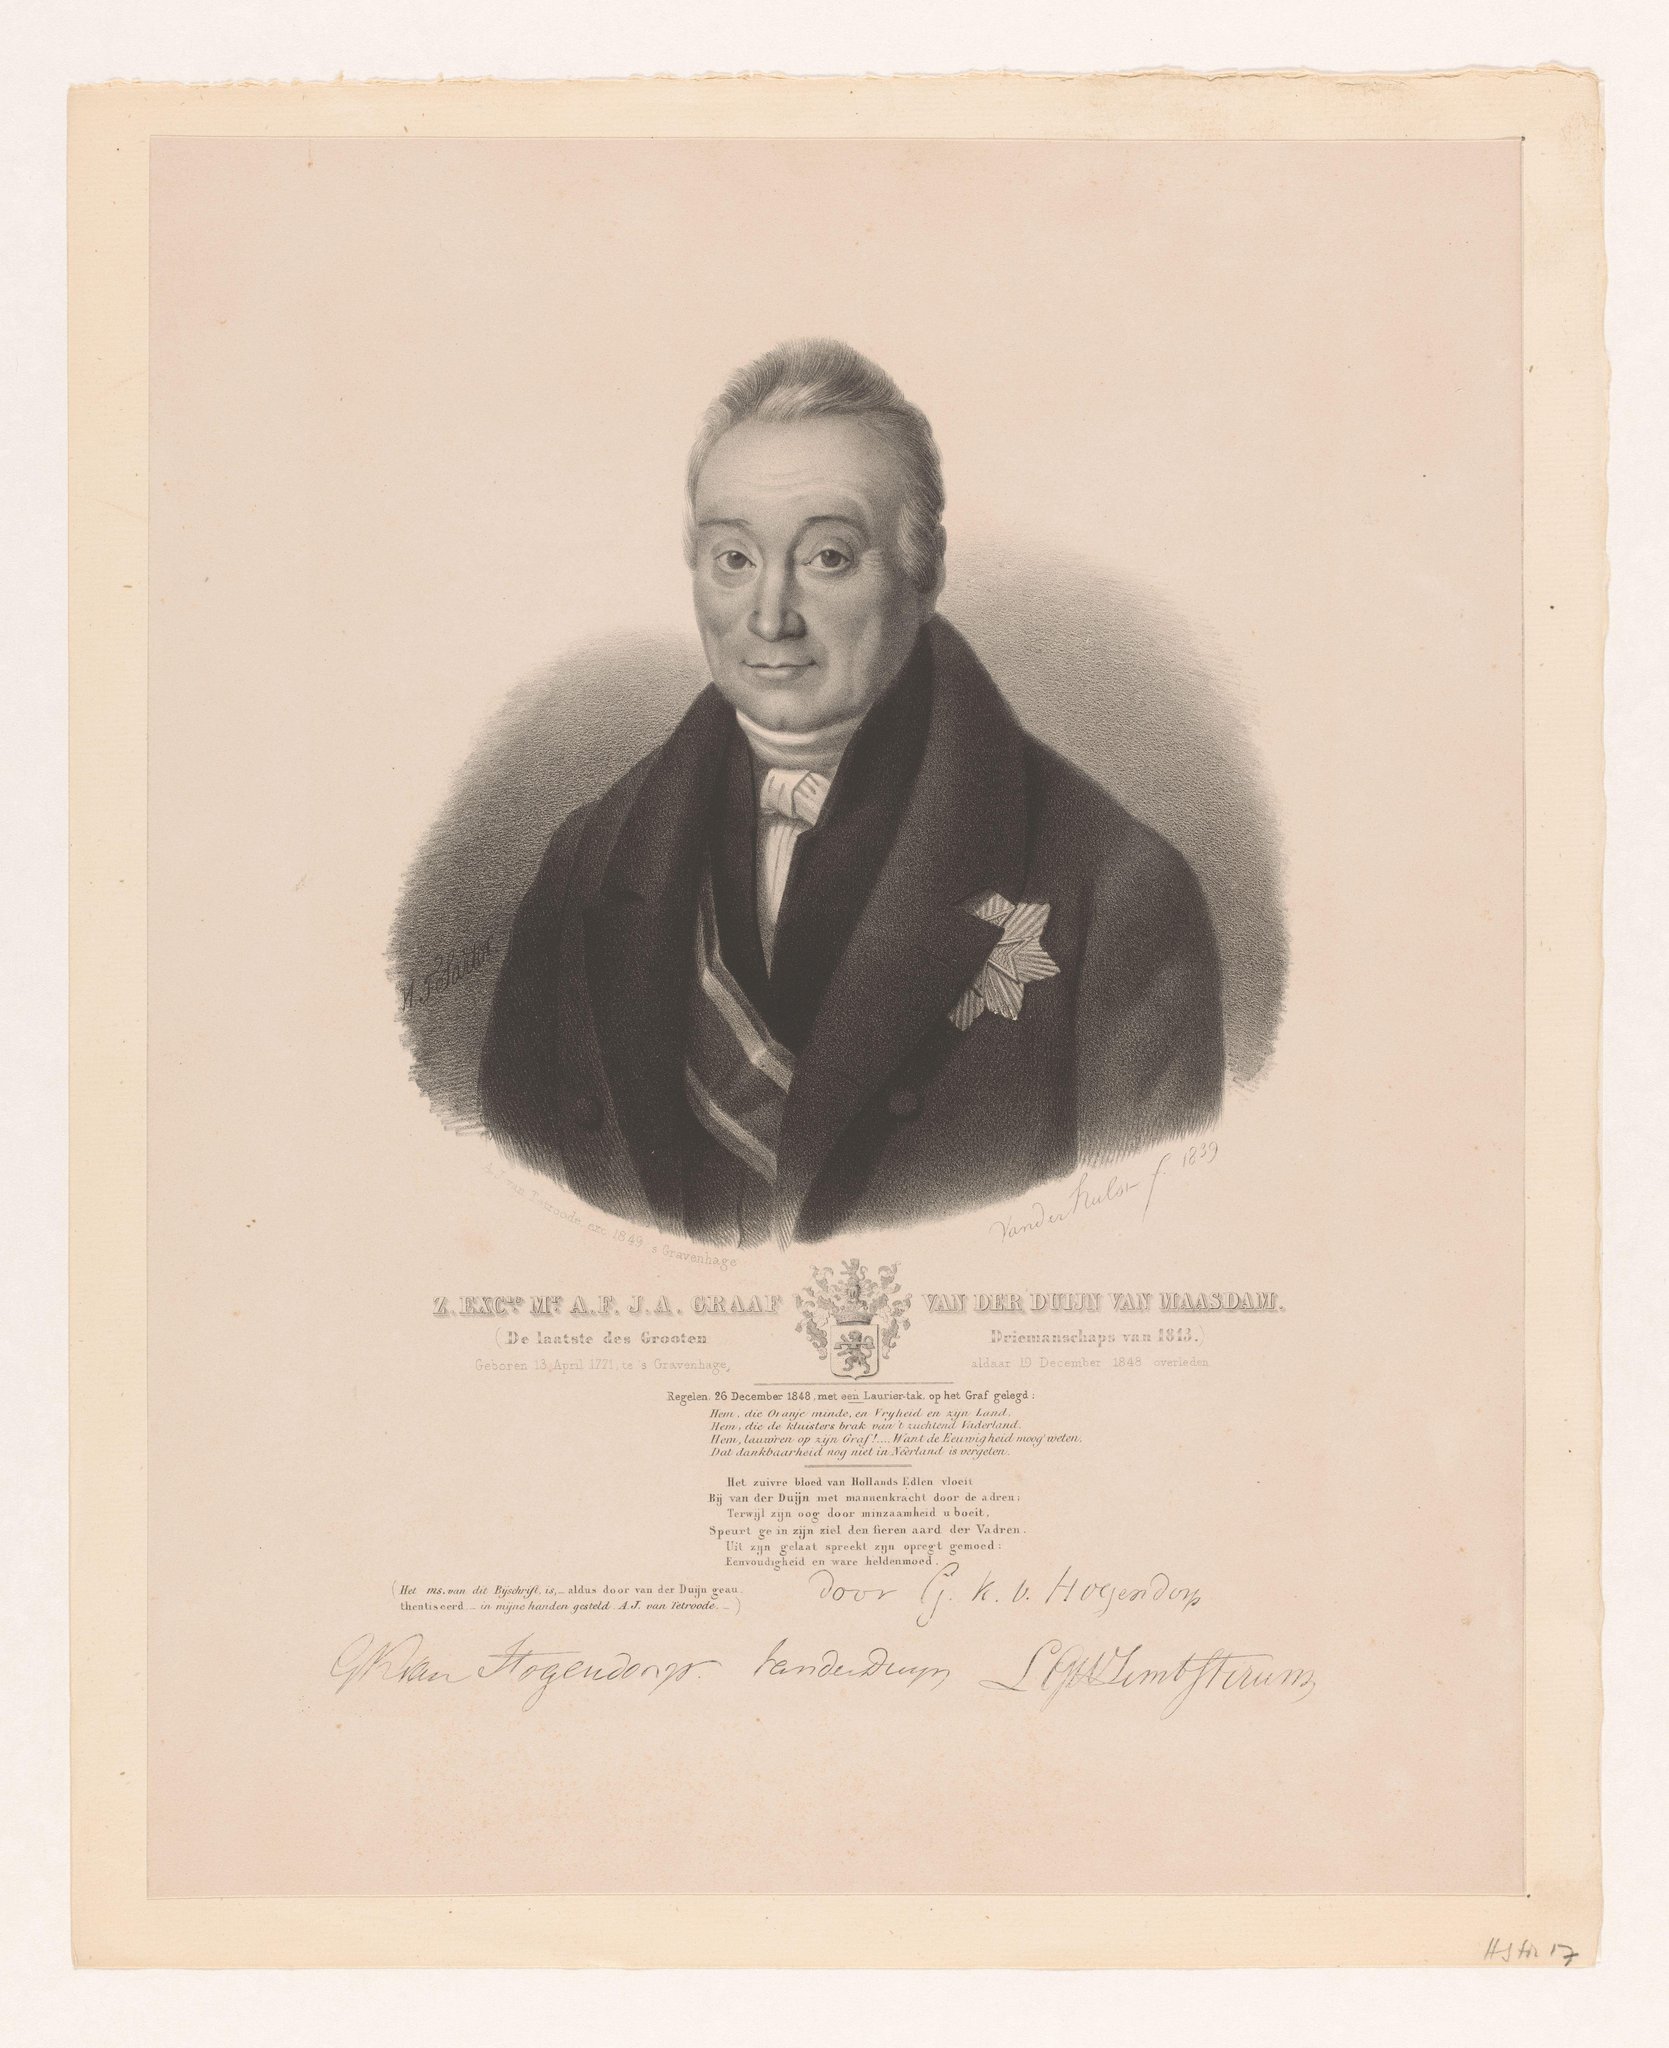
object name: print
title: Z. Excie Mr A.F.J.A. Graaf van der Duijn van Maasdam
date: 1839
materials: paper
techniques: lithograph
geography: the hague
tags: rotterdam, the hague, gijsbert karel graaf van hogendorp, deventer, adam françois jules armand van der duyn, historical persons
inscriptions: collector's mark: Lugt 2228, collector's mark: Lugt 2760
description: Onder het portret de signaturen van Gijsbert Karel van Hogendorp, de geportretteerde en Leopold van Limburg Stirum.